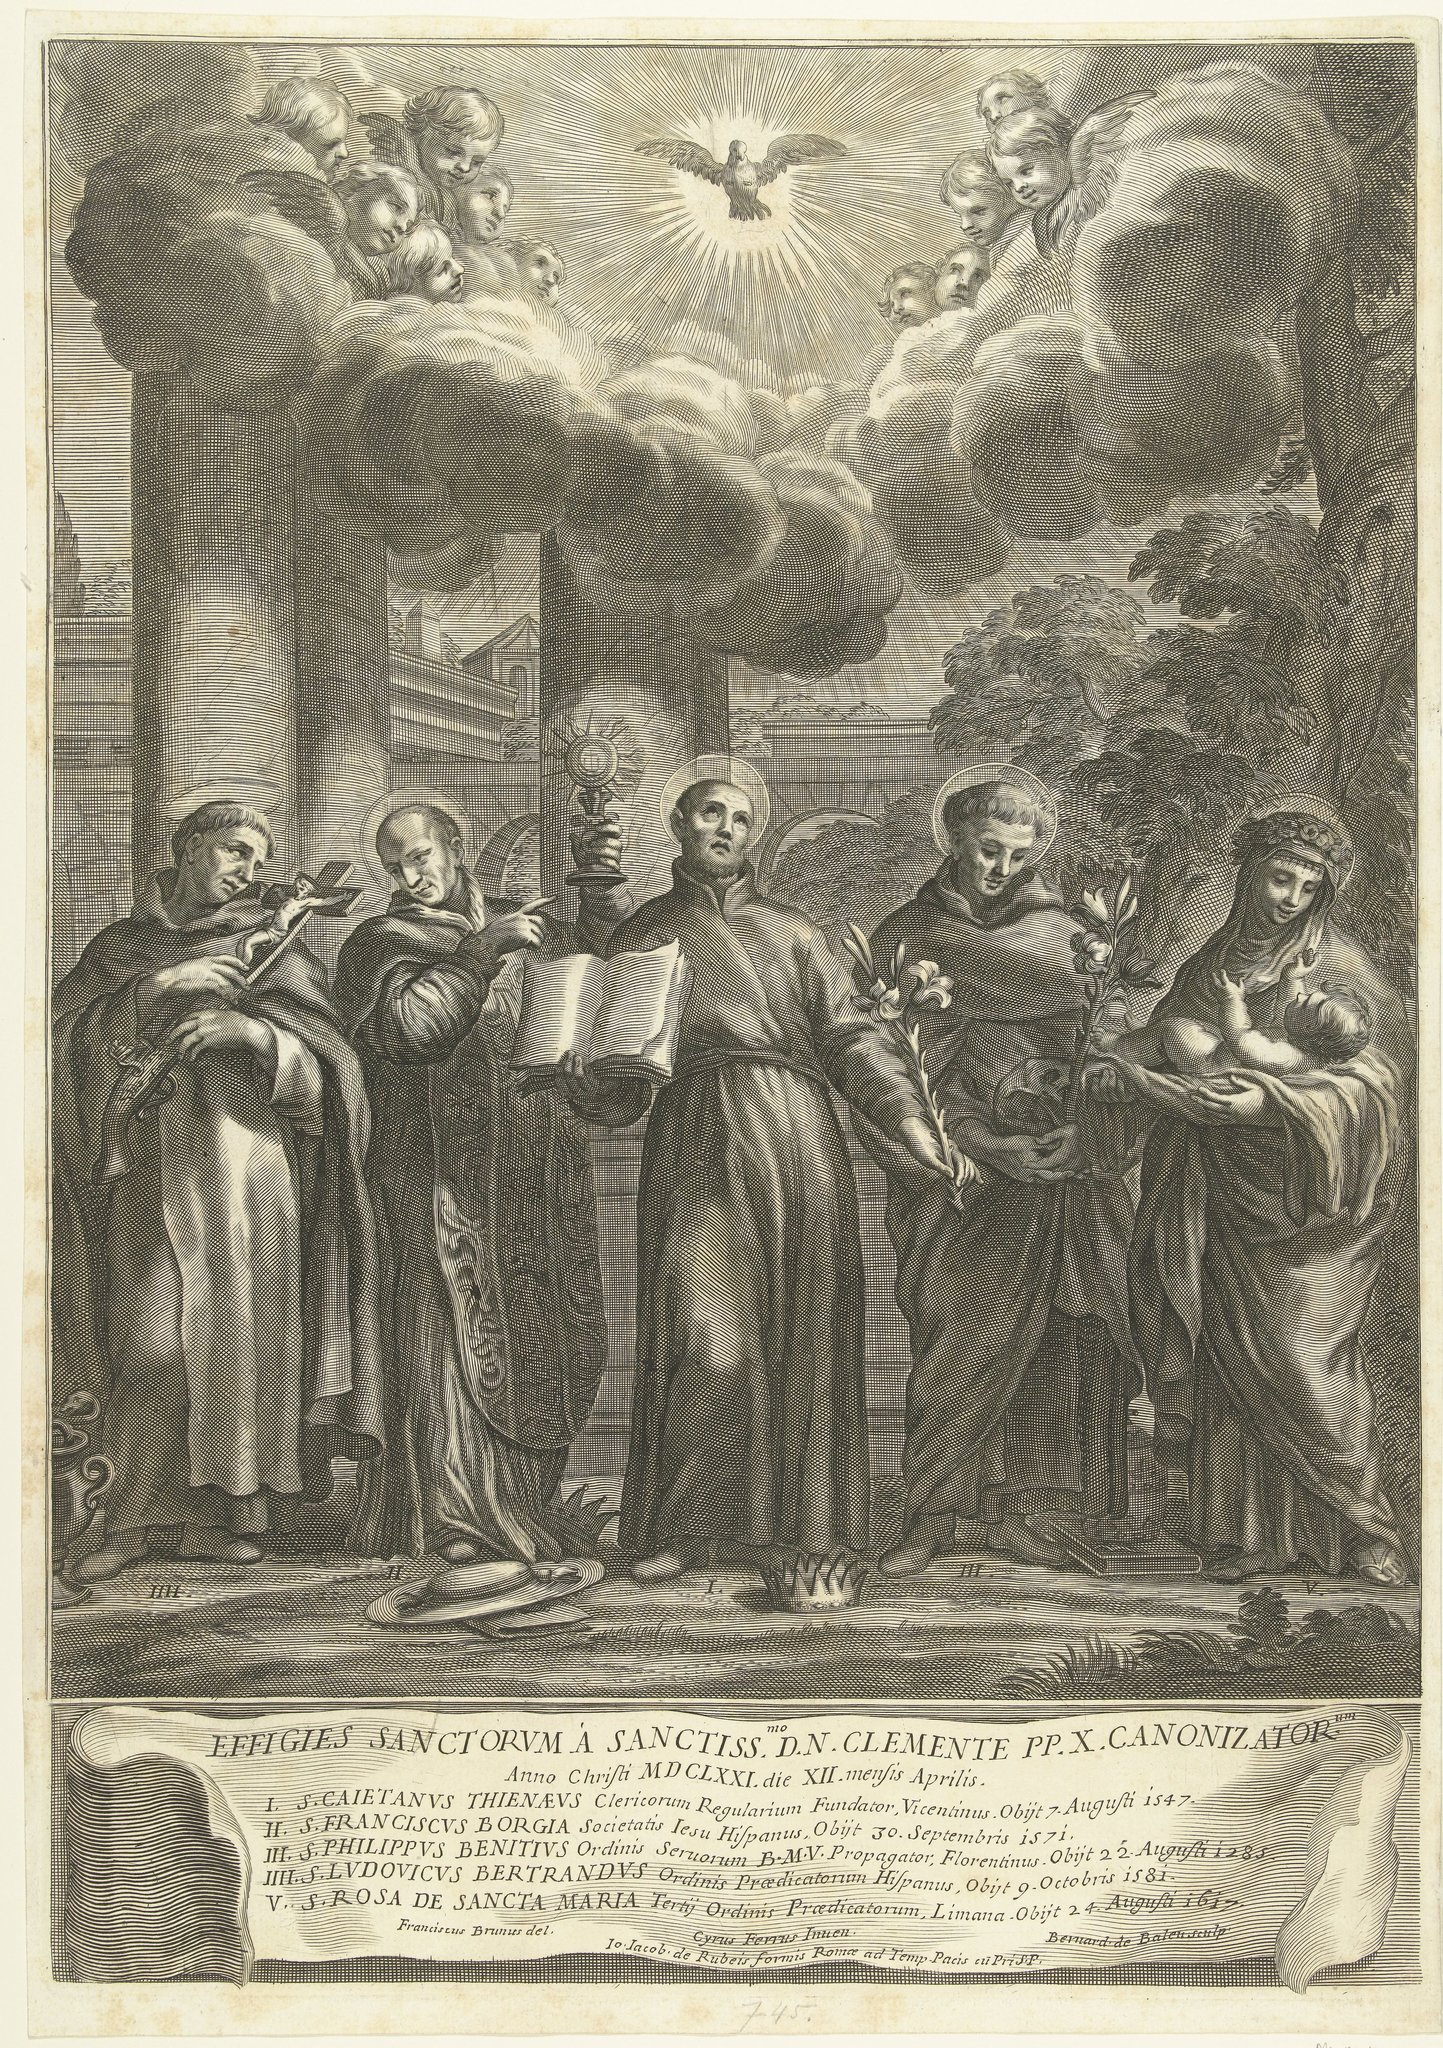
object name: print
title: Vijf heiligen die door paus Clemens X gecanoniseerd zijn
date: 1651-1704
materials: paper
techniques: engraving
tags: clemens x, saints, female saints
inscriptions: collector's mark: Lugt 2228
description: Vier mannelijke heiligen en een vrouwelijke heilige staan met hun attributen voor een zuilengallerij. Van links naar rechts: Ludovicus Beltrán met pistool dat in crucifix veranderd is, Franciscus Borgia met hostie, Cajetanus van Thiene met lelietak, Philippus Benitius met schedel en de heilige Rosa van Lima met rozenkrans en het Christuskind. Boven hen verschijnt temidden van cherubijnen een duif als symbool van de Heilige Geest. Op een cartouche onder de voorstelling staan de namen van de heiligen met de data waarop zij stierven.